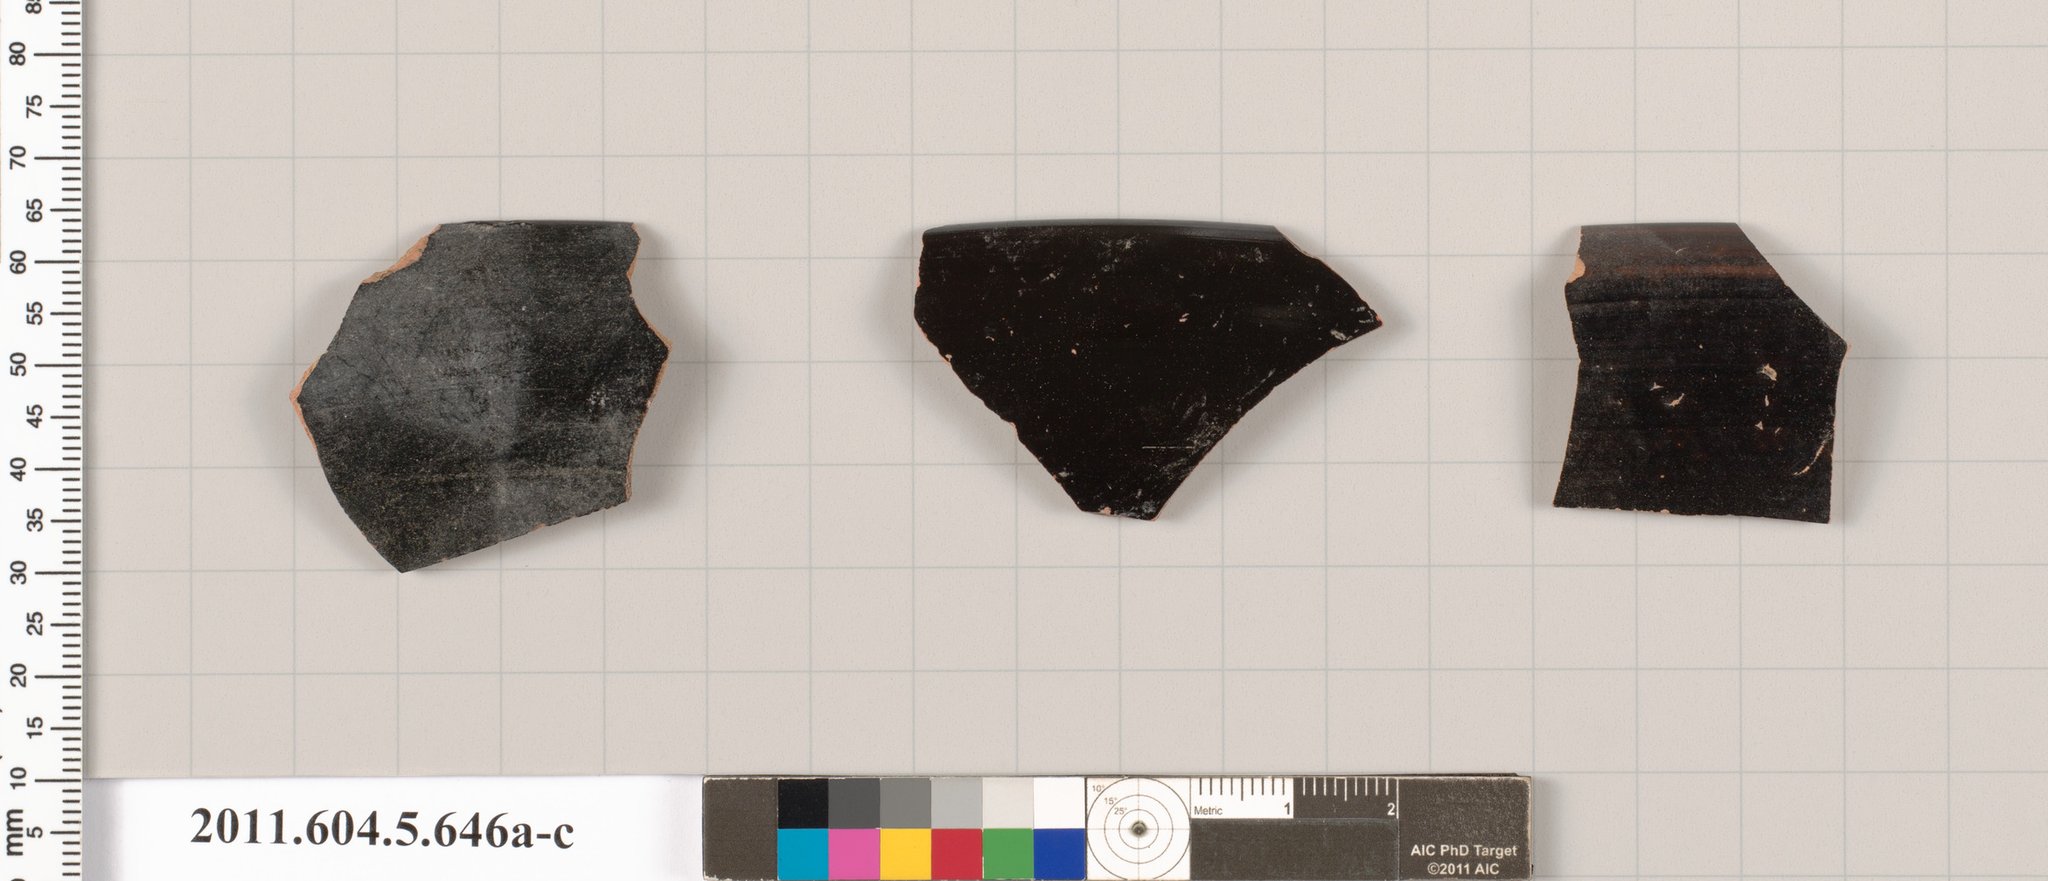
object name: kylix fragment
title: Terracotta rim fragments of kylikes (drinking cups)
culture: greek, attic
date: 600-401 BCE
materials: terracotta